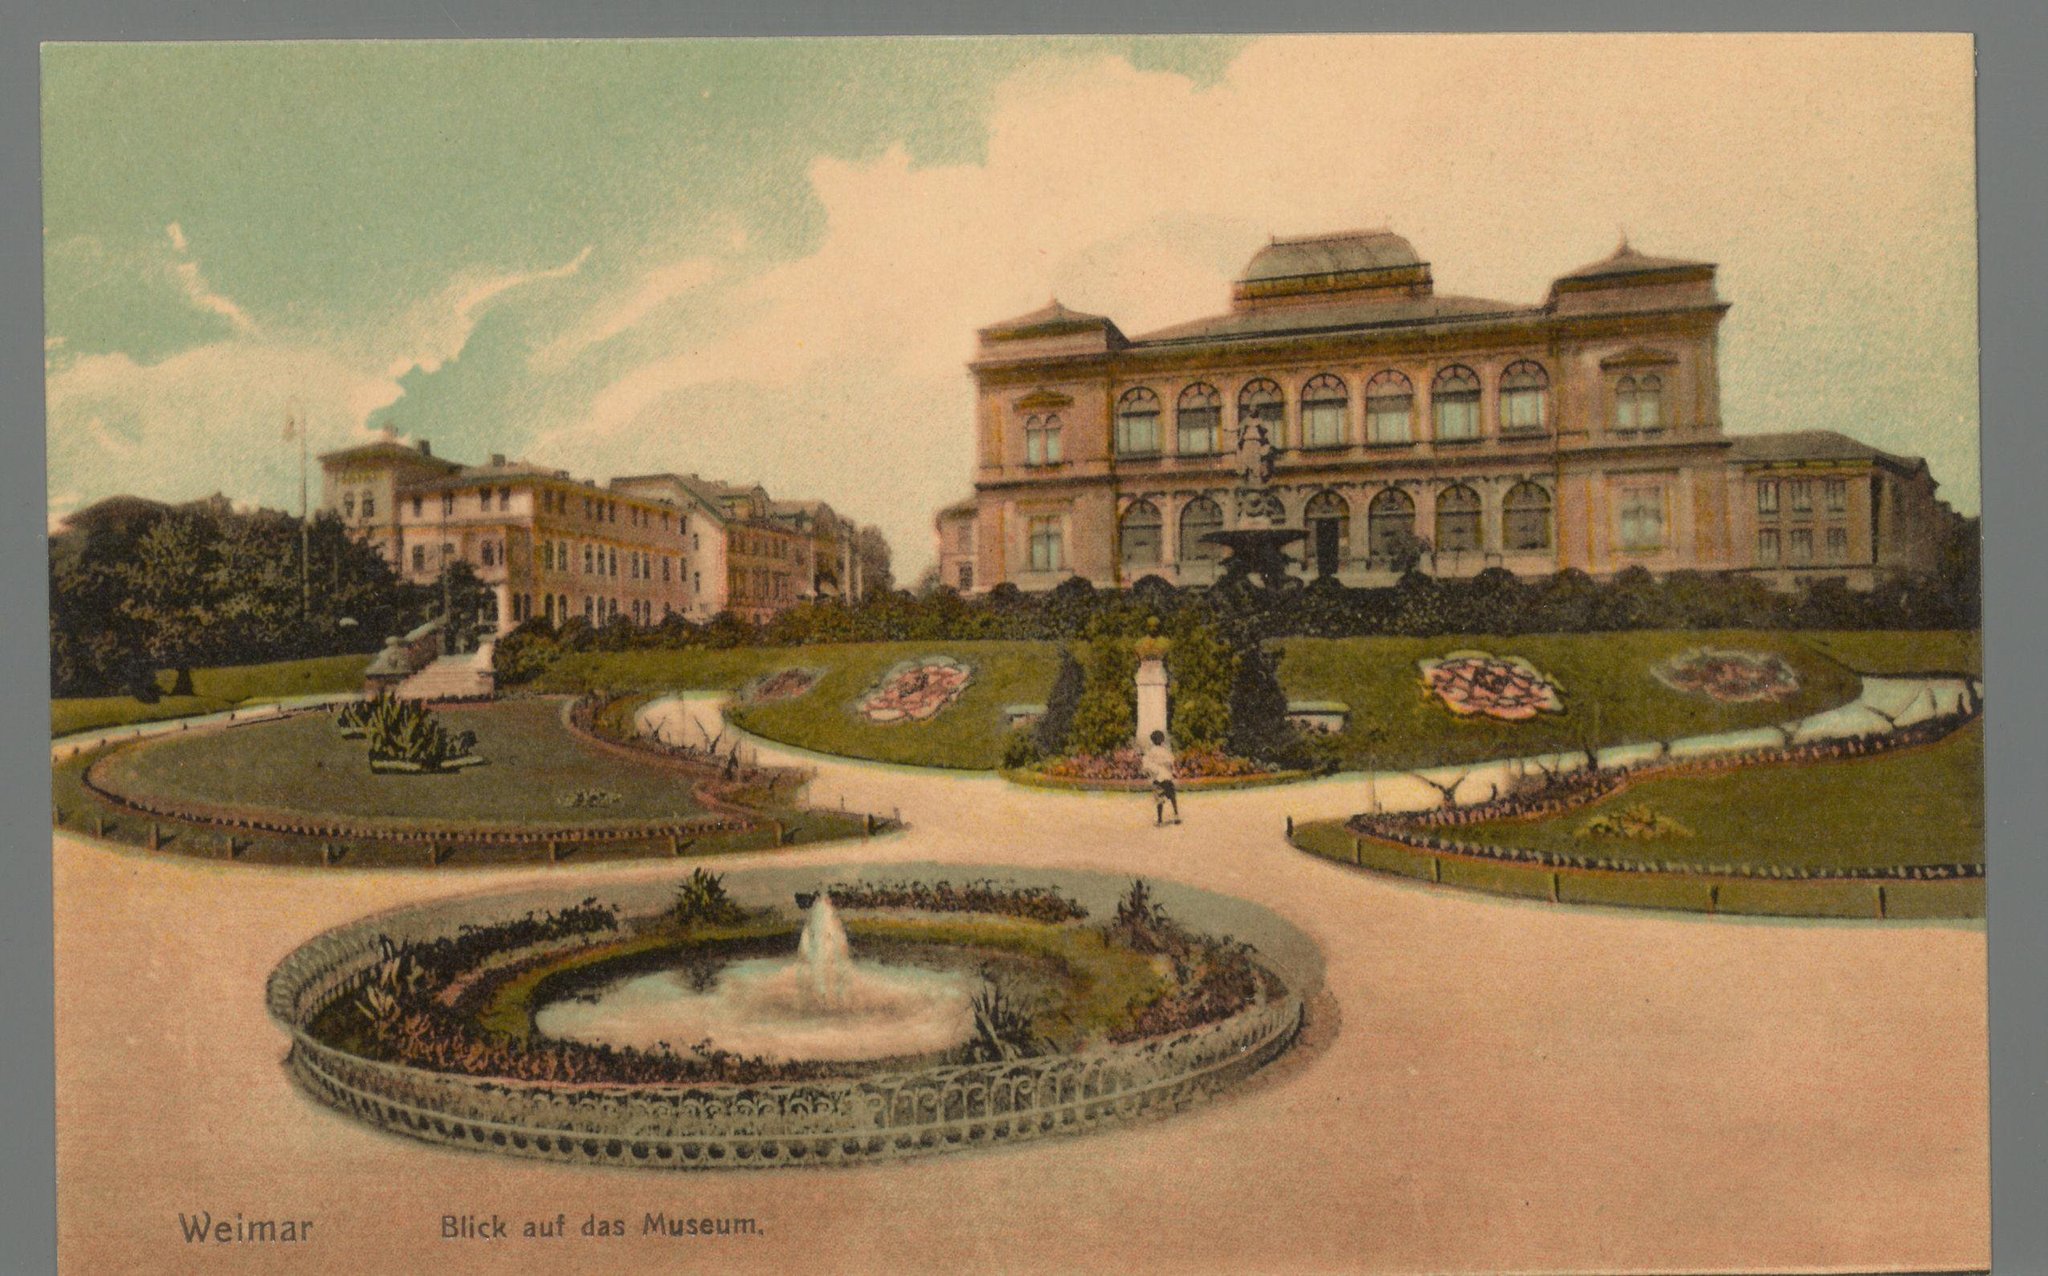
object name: photomechanical print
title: Weimar. Blick auf das Museum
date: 1905-1930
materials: cardboard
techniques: photograph, lithograph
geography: hamburg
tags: monument, statue, permanent exhibition, museum, ornamental fountain